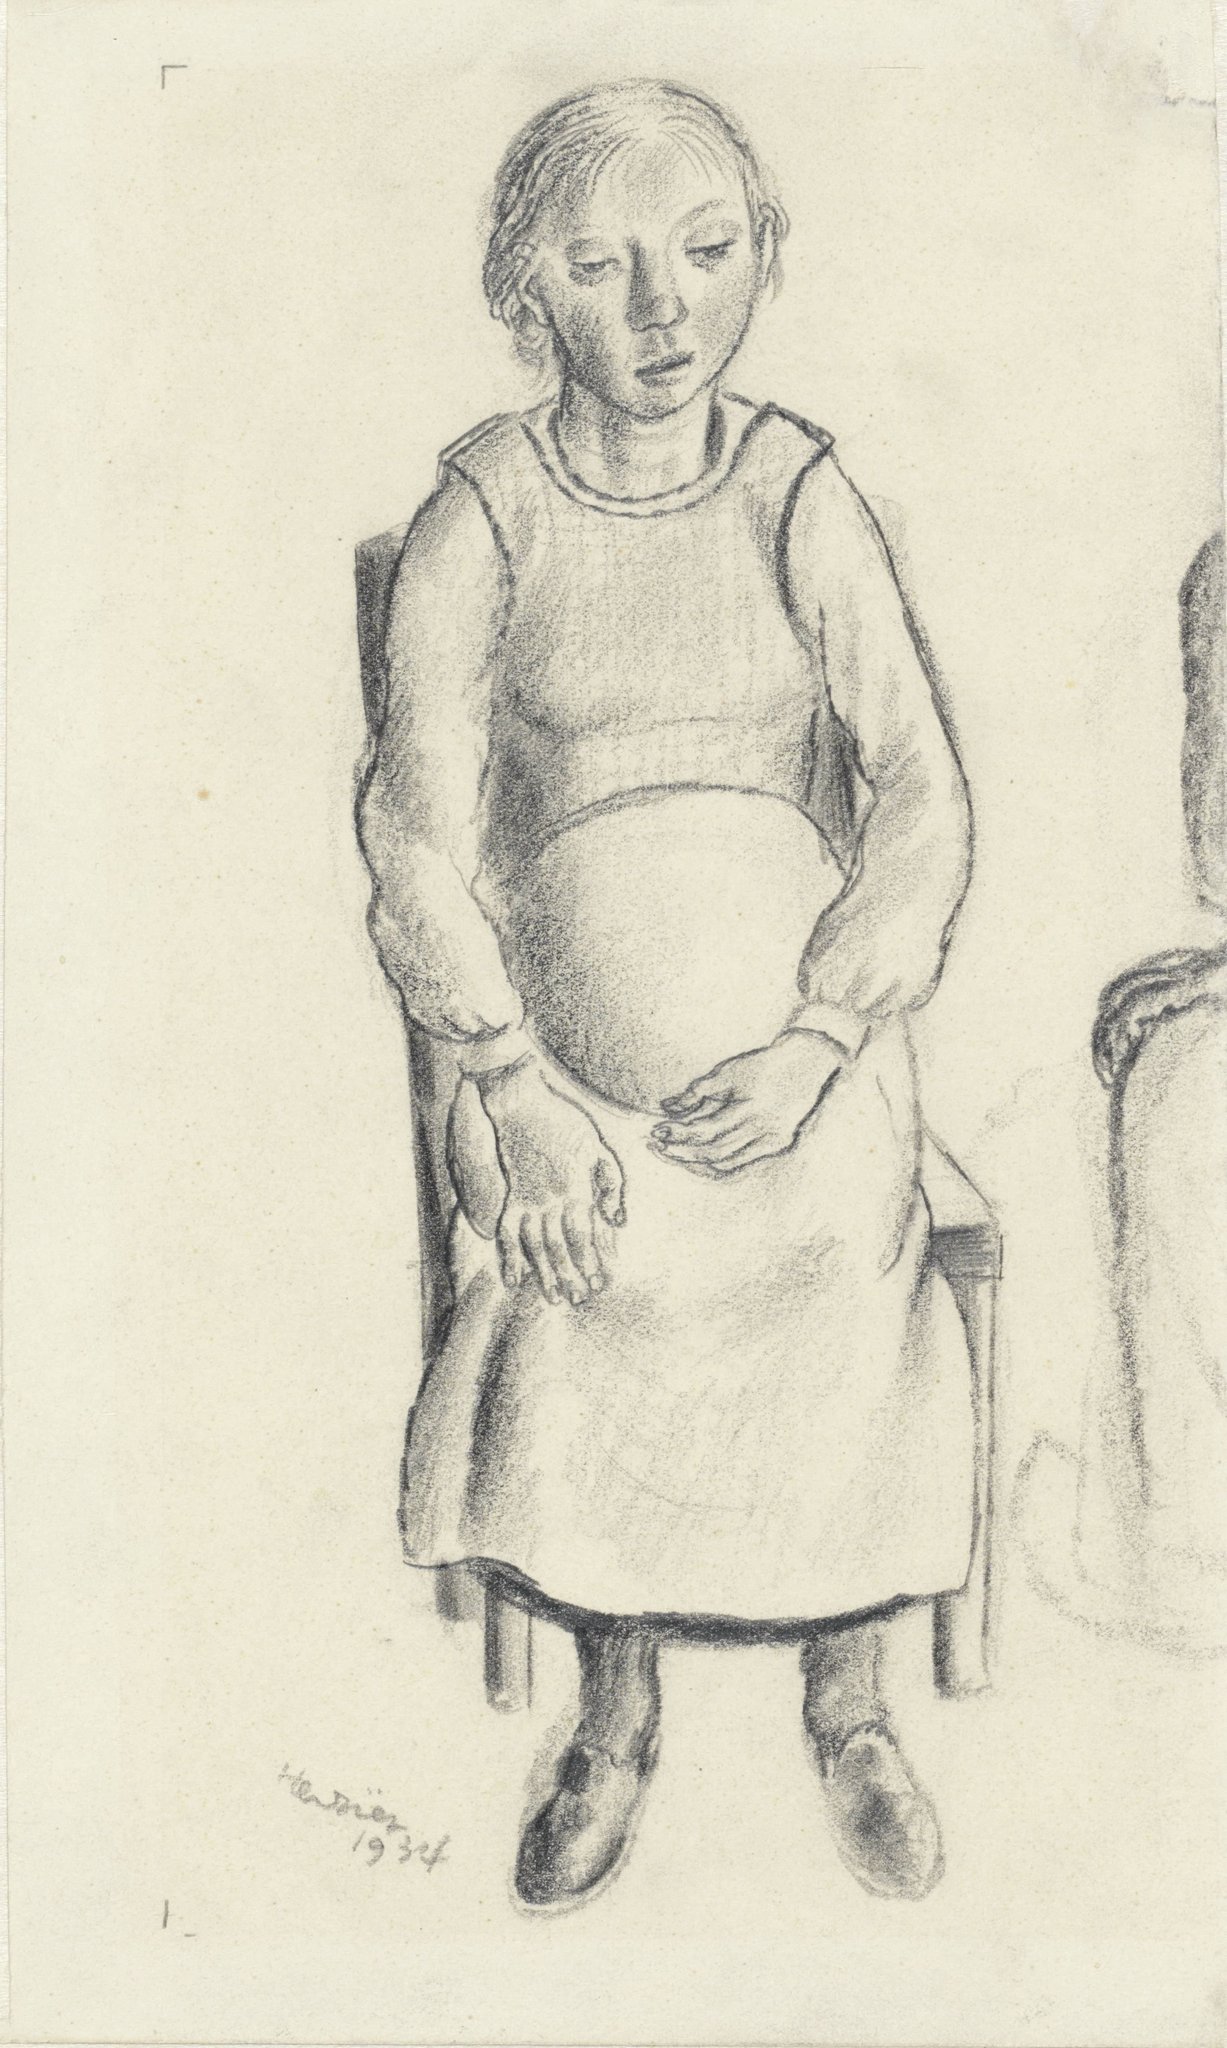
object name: drawing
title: Zwangere vrouw zittend op een stoel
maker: henk henriët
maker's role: draughtsman, print maker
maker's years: 1903-1945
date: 1934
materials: paper, pencil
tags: sitting on an elevation - aa - female human figure, pregnant woman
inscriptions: collector's mark: Lugt 2228, inscription: ‘Mr. Kist’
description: De geportretteerde vrouw is mogelijk de vrouw van de kunstenaar, genaamd Gerarda Antonia Maria Tonia Sluijter.